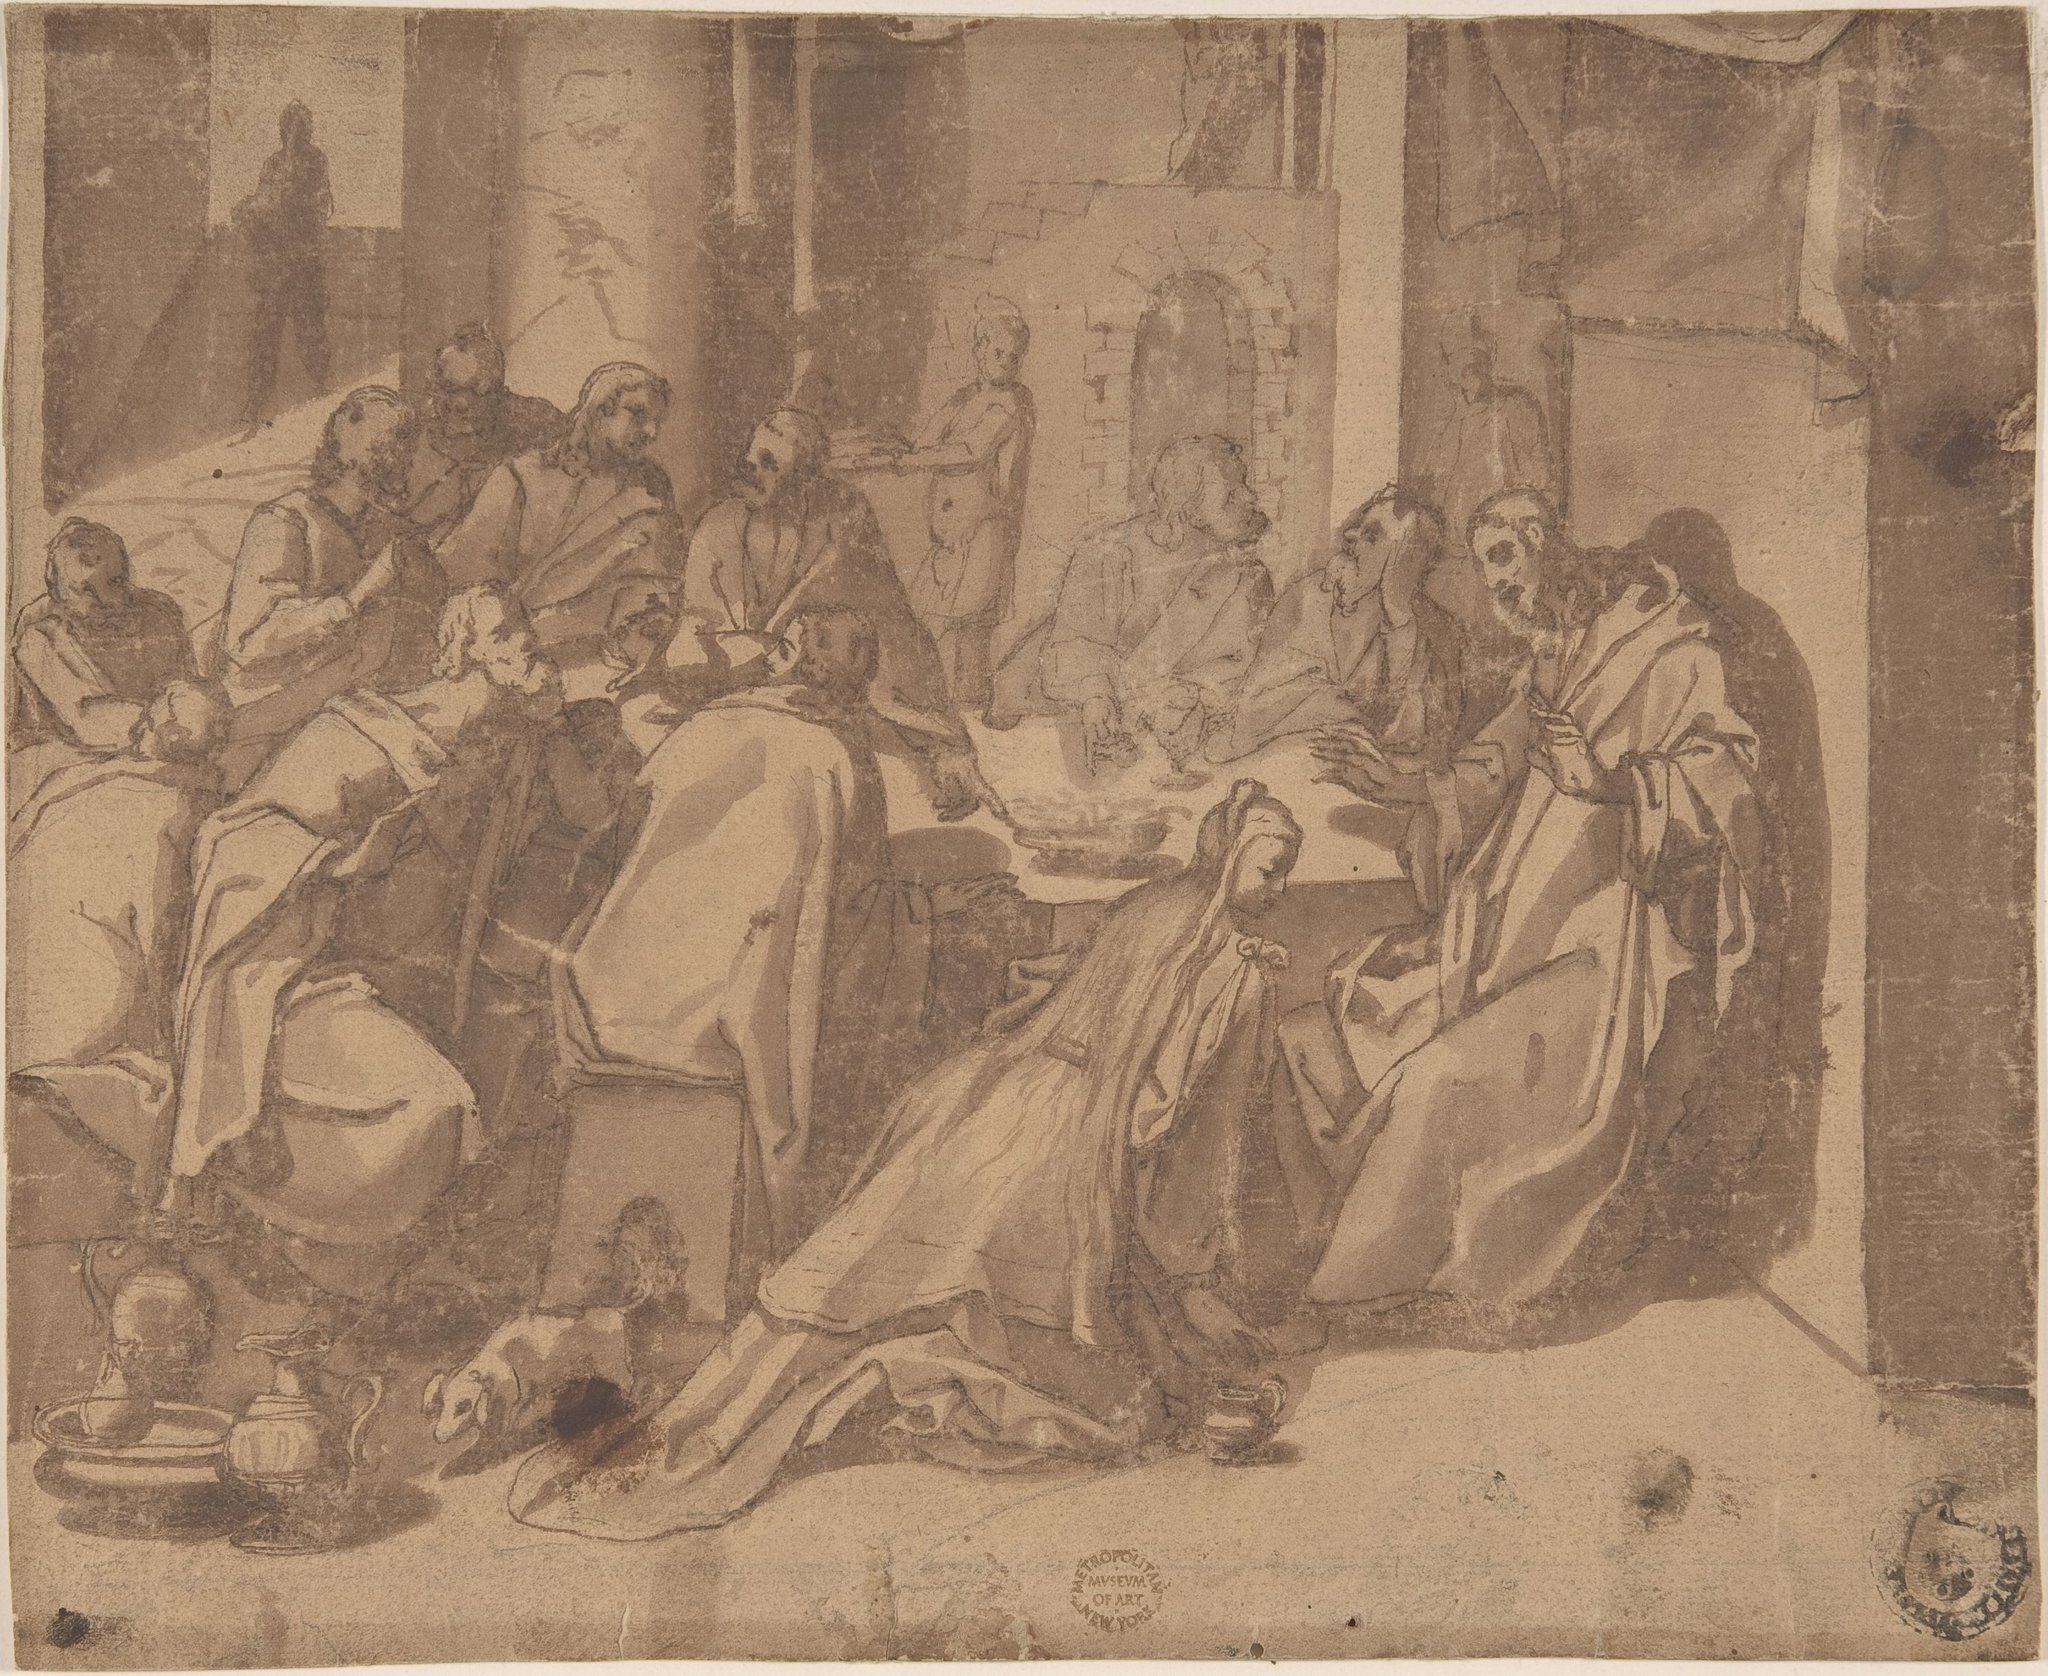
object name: drawing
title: Mary Magdalen Annointing the Feet of Christ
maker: raffaellino da reggio (raffaello motta)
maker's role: artist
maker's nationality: italian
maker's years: 1545-1578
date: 1570-1573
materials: chalk, ink, paper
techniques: brush, pen, wash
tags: christ,mary magdalene